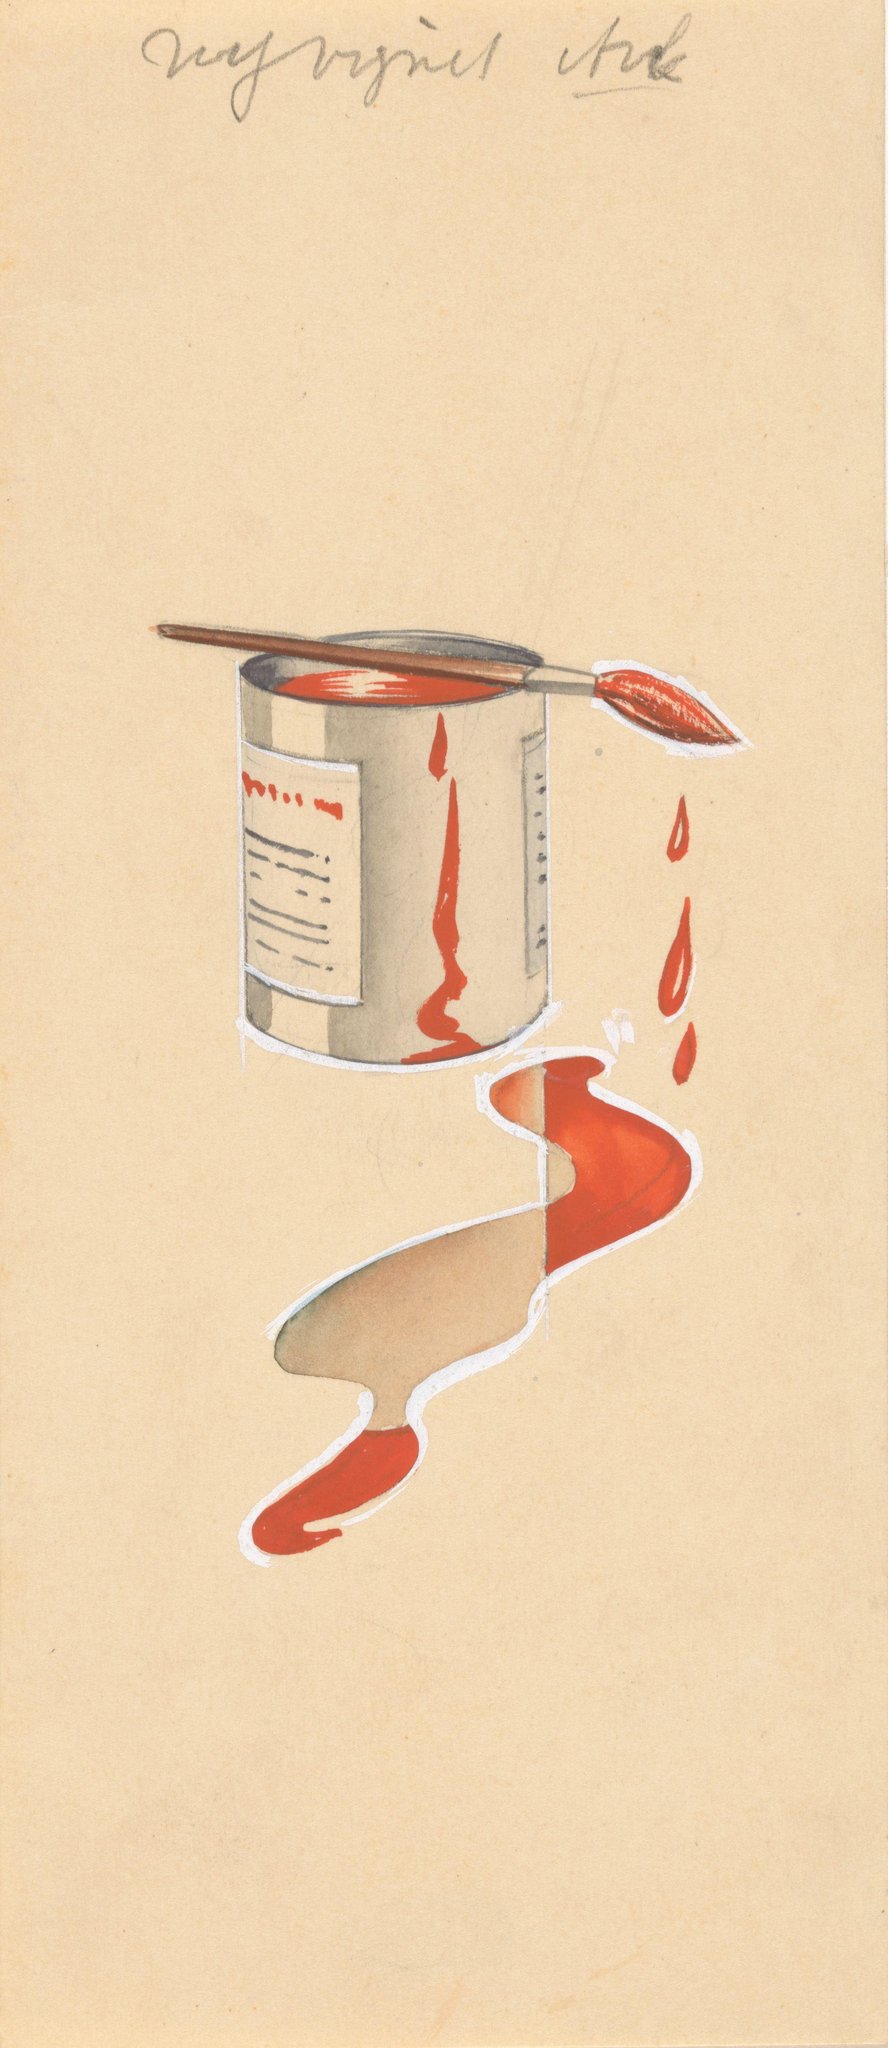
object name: boekillustratie ontwerp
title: Blik rode verf met kwast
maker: hans borrebach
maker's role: draughtsman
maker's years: 1903-1991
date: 1913-1970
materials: paint, paper, pencil, watercolor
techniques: brush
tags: brushes ~ implements of painter, colours, pigments, and paints, container of metal: bucket, can, canister, drum, tin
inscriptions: annotation: ‘[...] vignet Avk’, collector's mark: Lugt 2228a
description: Op een open blik met rode verf ligt een kwast waar verf vanaf druipt.